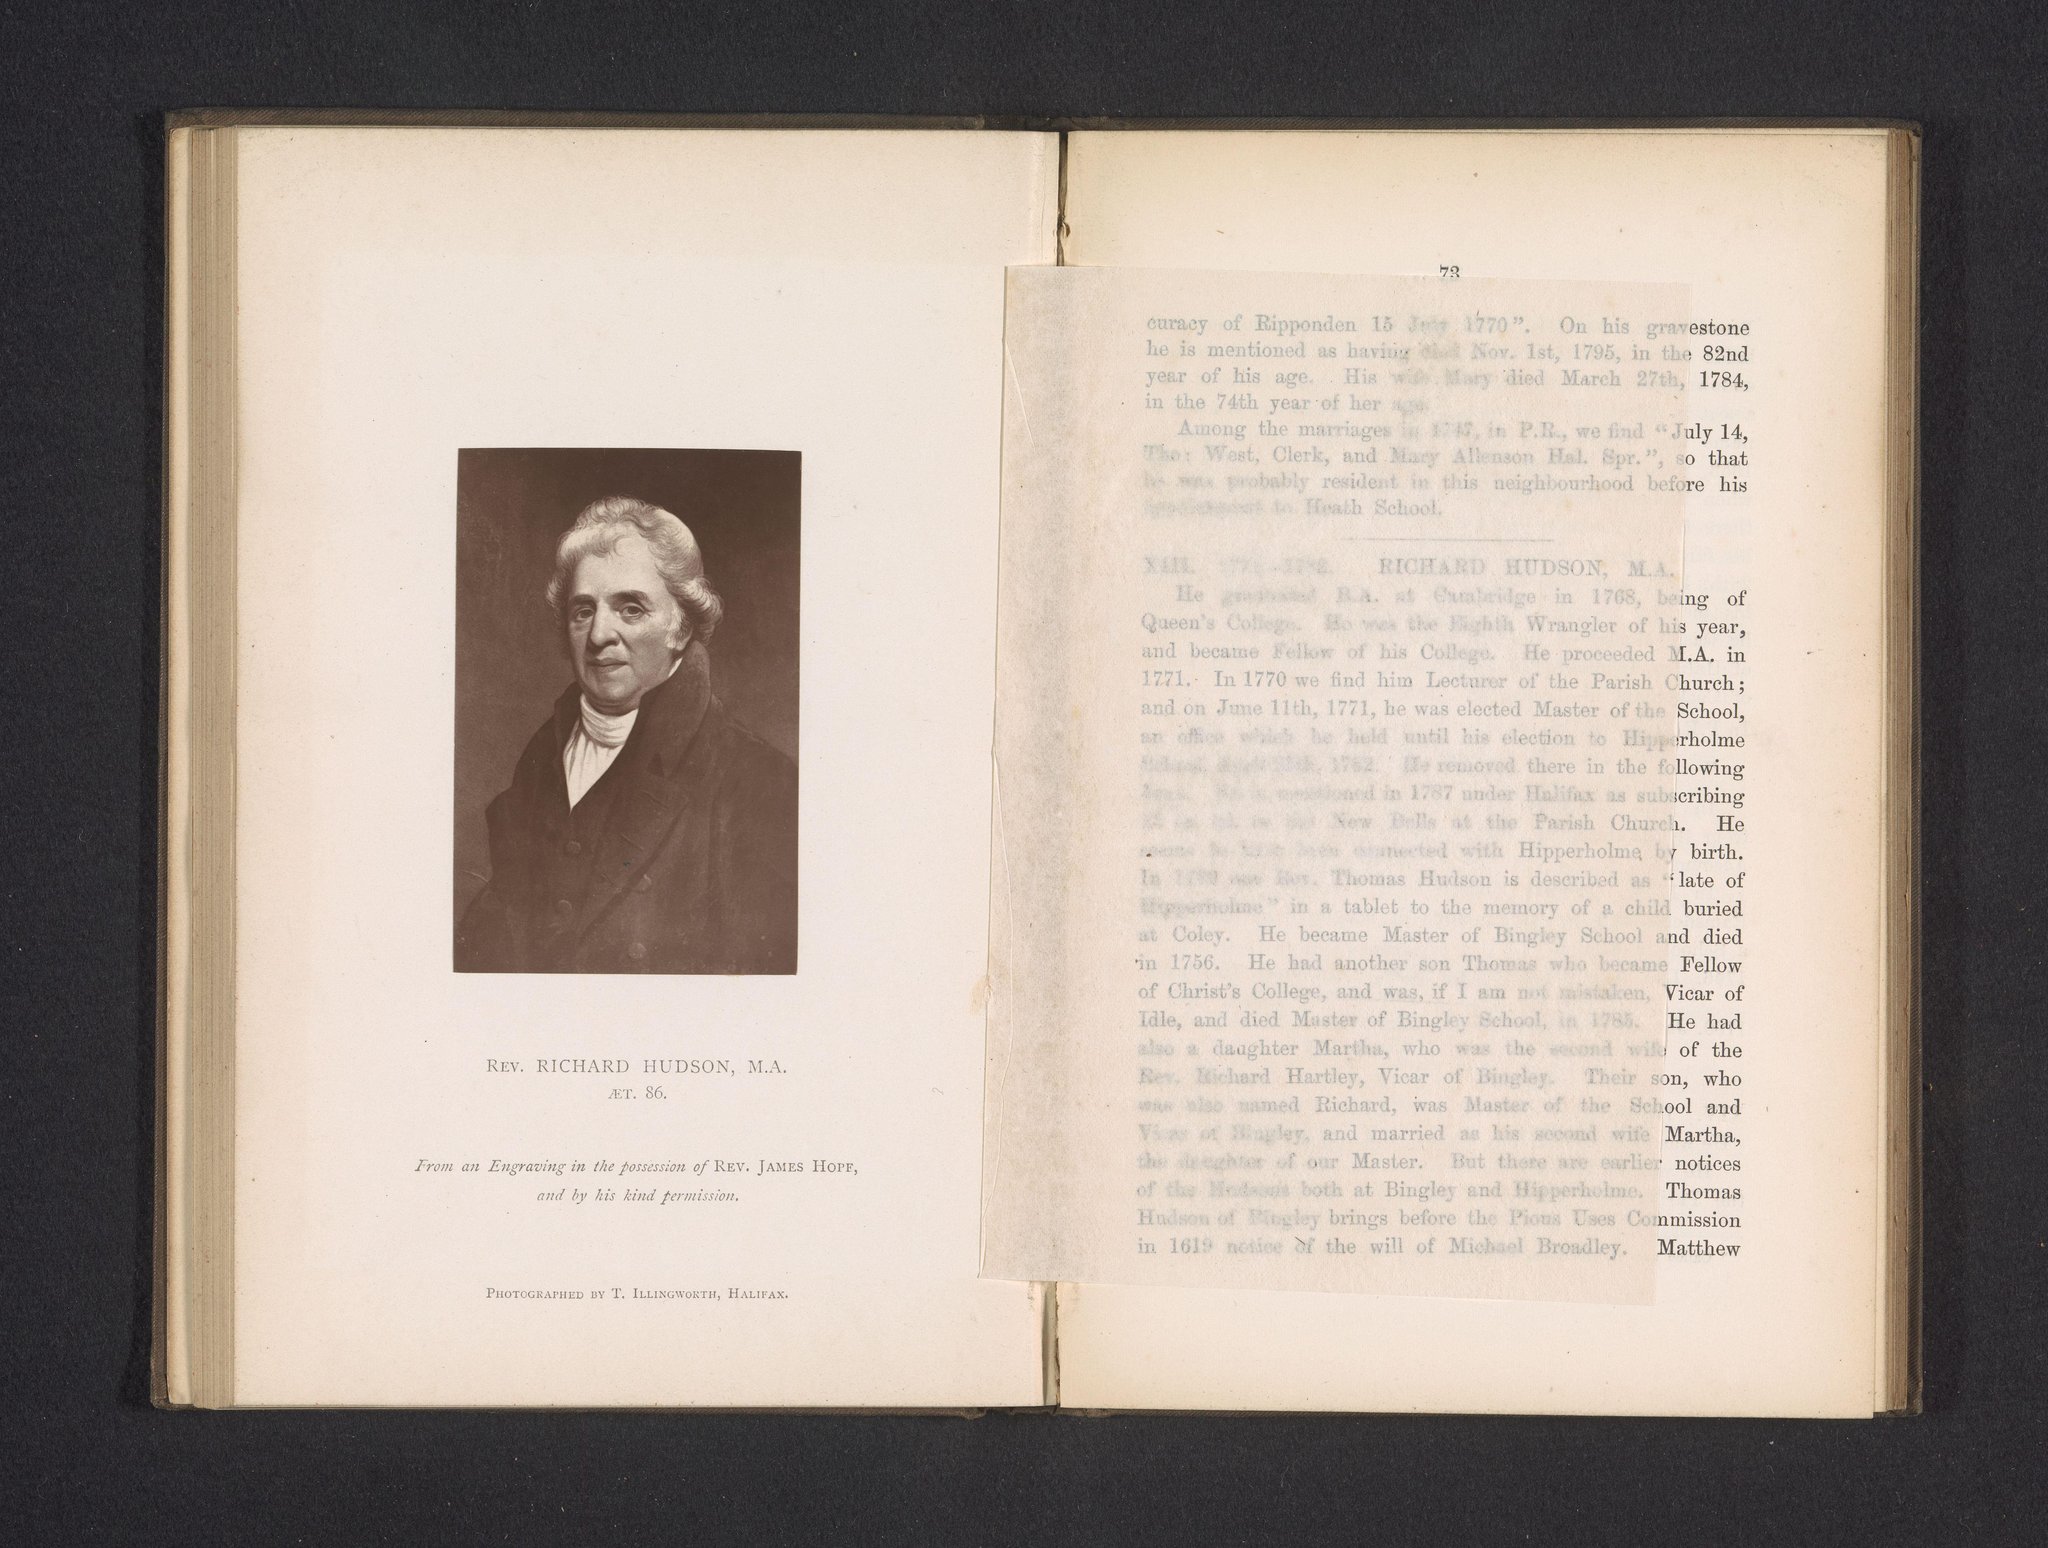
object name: photomechanical print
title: Fotoreproductie van een portret van Richard Hudson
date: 1869-1879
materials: paper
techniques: woodburytype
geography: halifax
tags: functionaries and dignitaries (with name) ~ protestant churches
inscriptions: inscription: ‘From an engraving in the posession of Rev. James Hope, and by his kind permission.’, number: ‘Aet. 86.’